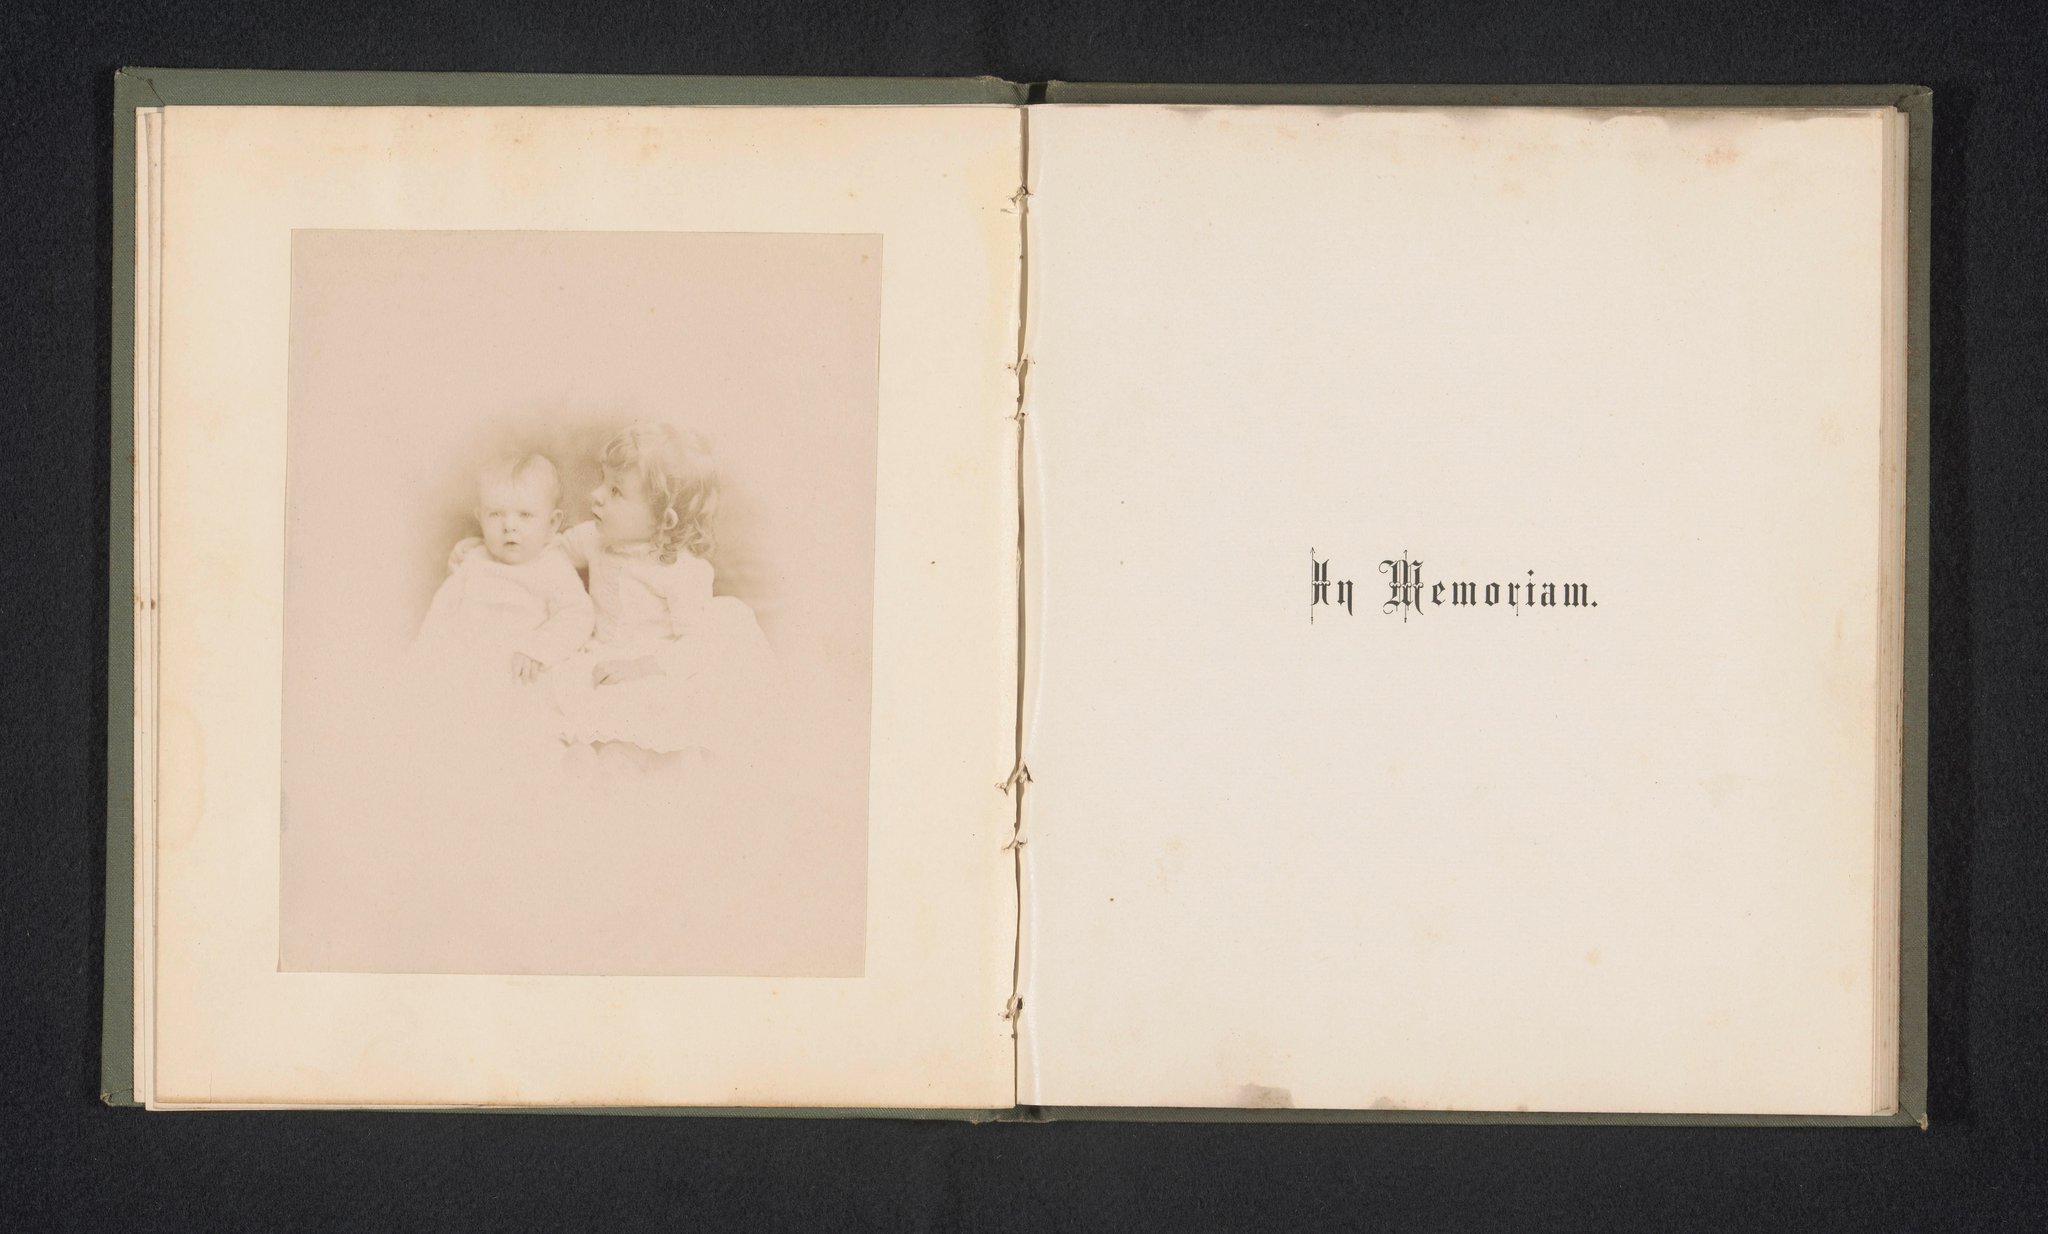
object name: photograph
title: Portret van Lucinda Butterfield McPherson en Adele May McPherson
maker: Anonymous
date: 1885-1888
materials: photographic support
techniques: albumen print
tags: child, infant, baby